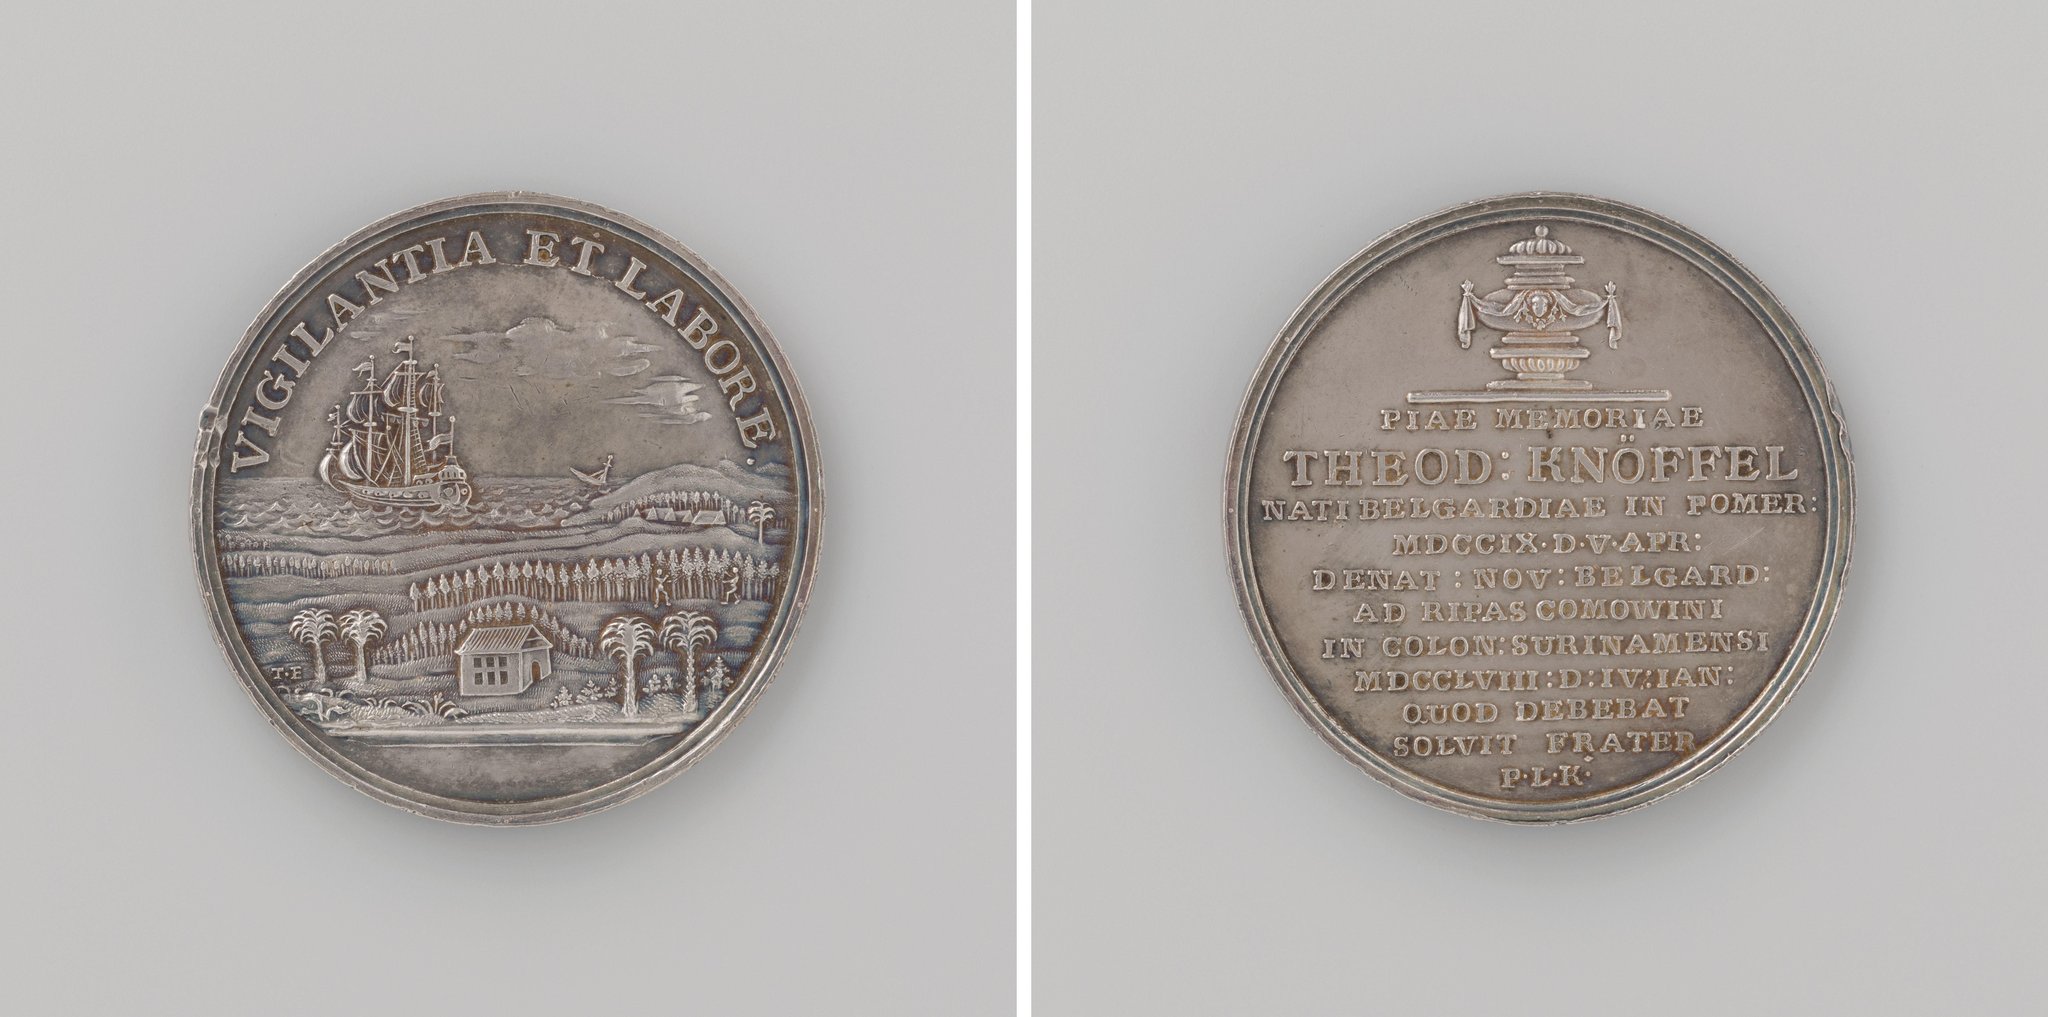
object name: overlijdenspenning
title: Overlijden van Theodorus Knöffel, stichter van de plantage Elisabeths Hoop in Suriname; penning geslagen op last van zijn broer P.L. Knöffel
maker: tobias ernst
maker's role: medailleur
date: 1758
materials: silver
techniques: striking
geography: berlin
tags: slavery; serfs and enslaved persons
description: Commemorative medal, by Tobias Ernst, 1758. Struck to commemorate the death of plantation owner Theodorus Knöffel (1709-1758). Knöffel owned the Surinamese plantation De Berg, which is depicted on the medal.